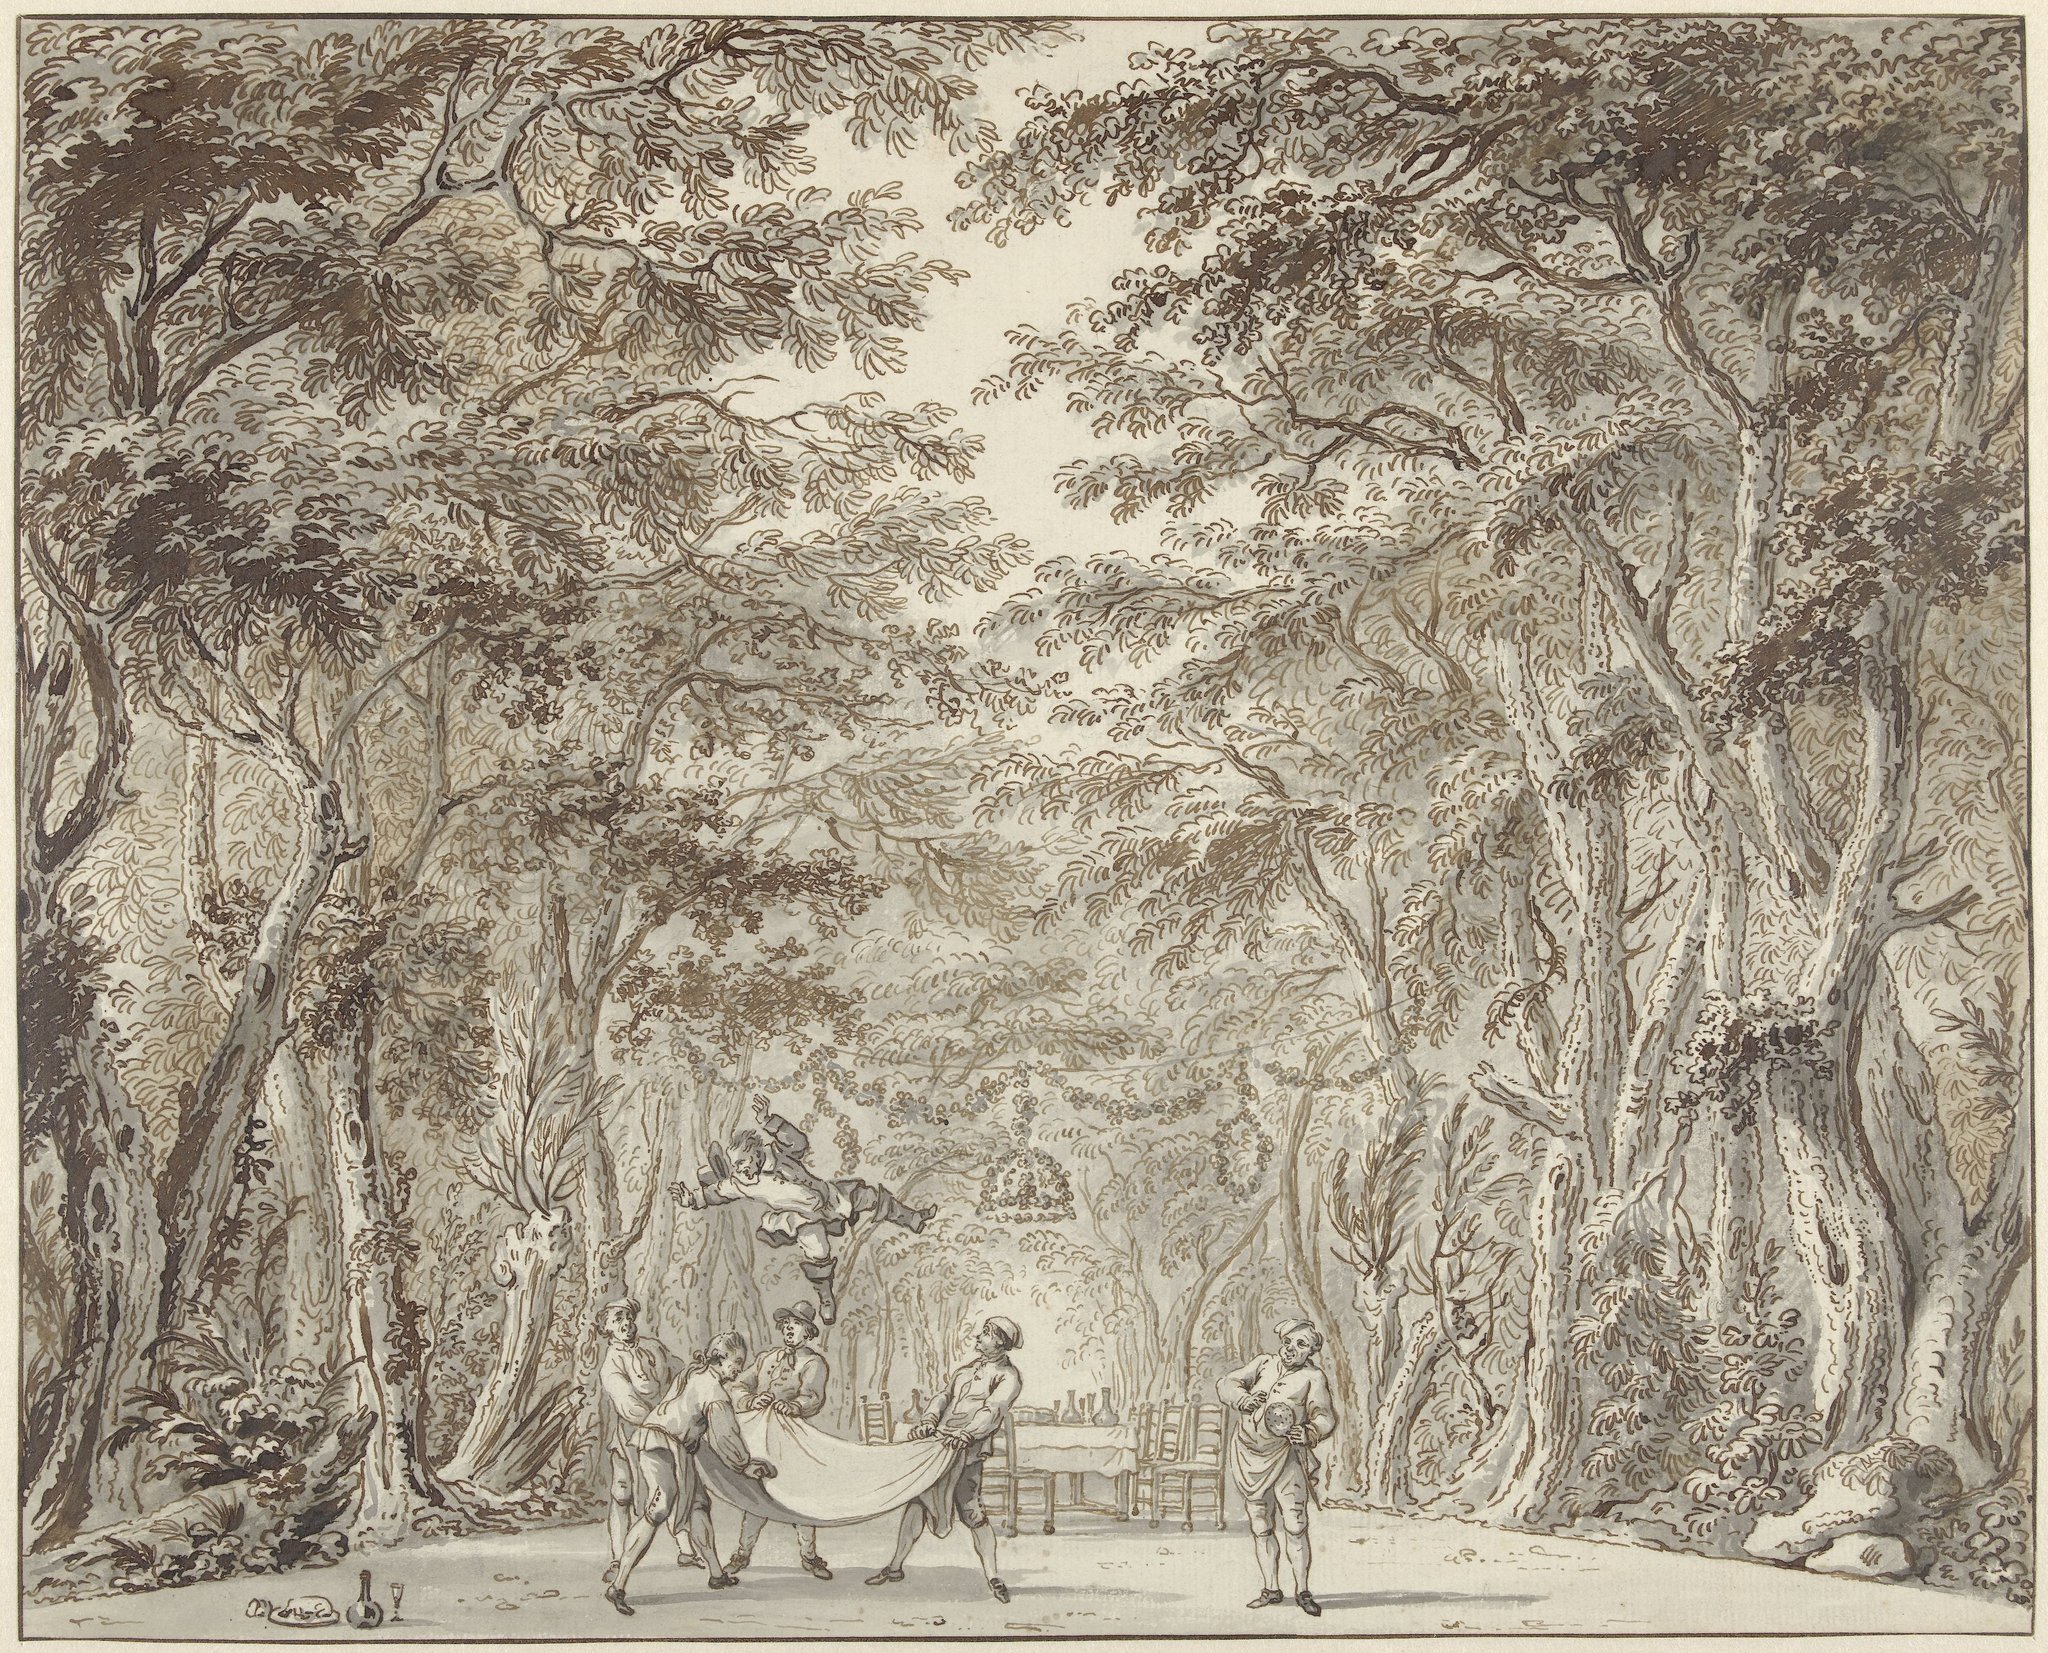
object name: drawing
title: Scène uit het toneelstuk Don Quichot op de Bruiloft van Camacho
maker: reinier vinkeles (i)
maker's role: draughtsman, print maker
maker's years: 1741-1816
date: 1751-1816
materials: ink, paper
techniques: brush, pen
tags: set, scenery ~ stage, don quixote, amsterdam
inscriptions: inscription: ‘Het Bosch / met Donquichot op de Bruiloft van Camacho / R: Vinkeles Del: Onwtwerp voor ecor `Het Bosch' in de Schouwburg te Amsterdam’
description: Scène uit het toneelstuk Don Quichot op de Bruiloft van Camacho: vier man gooien met een laken een vijfde in de lucht. Ontwerp voor een toneeldecor.